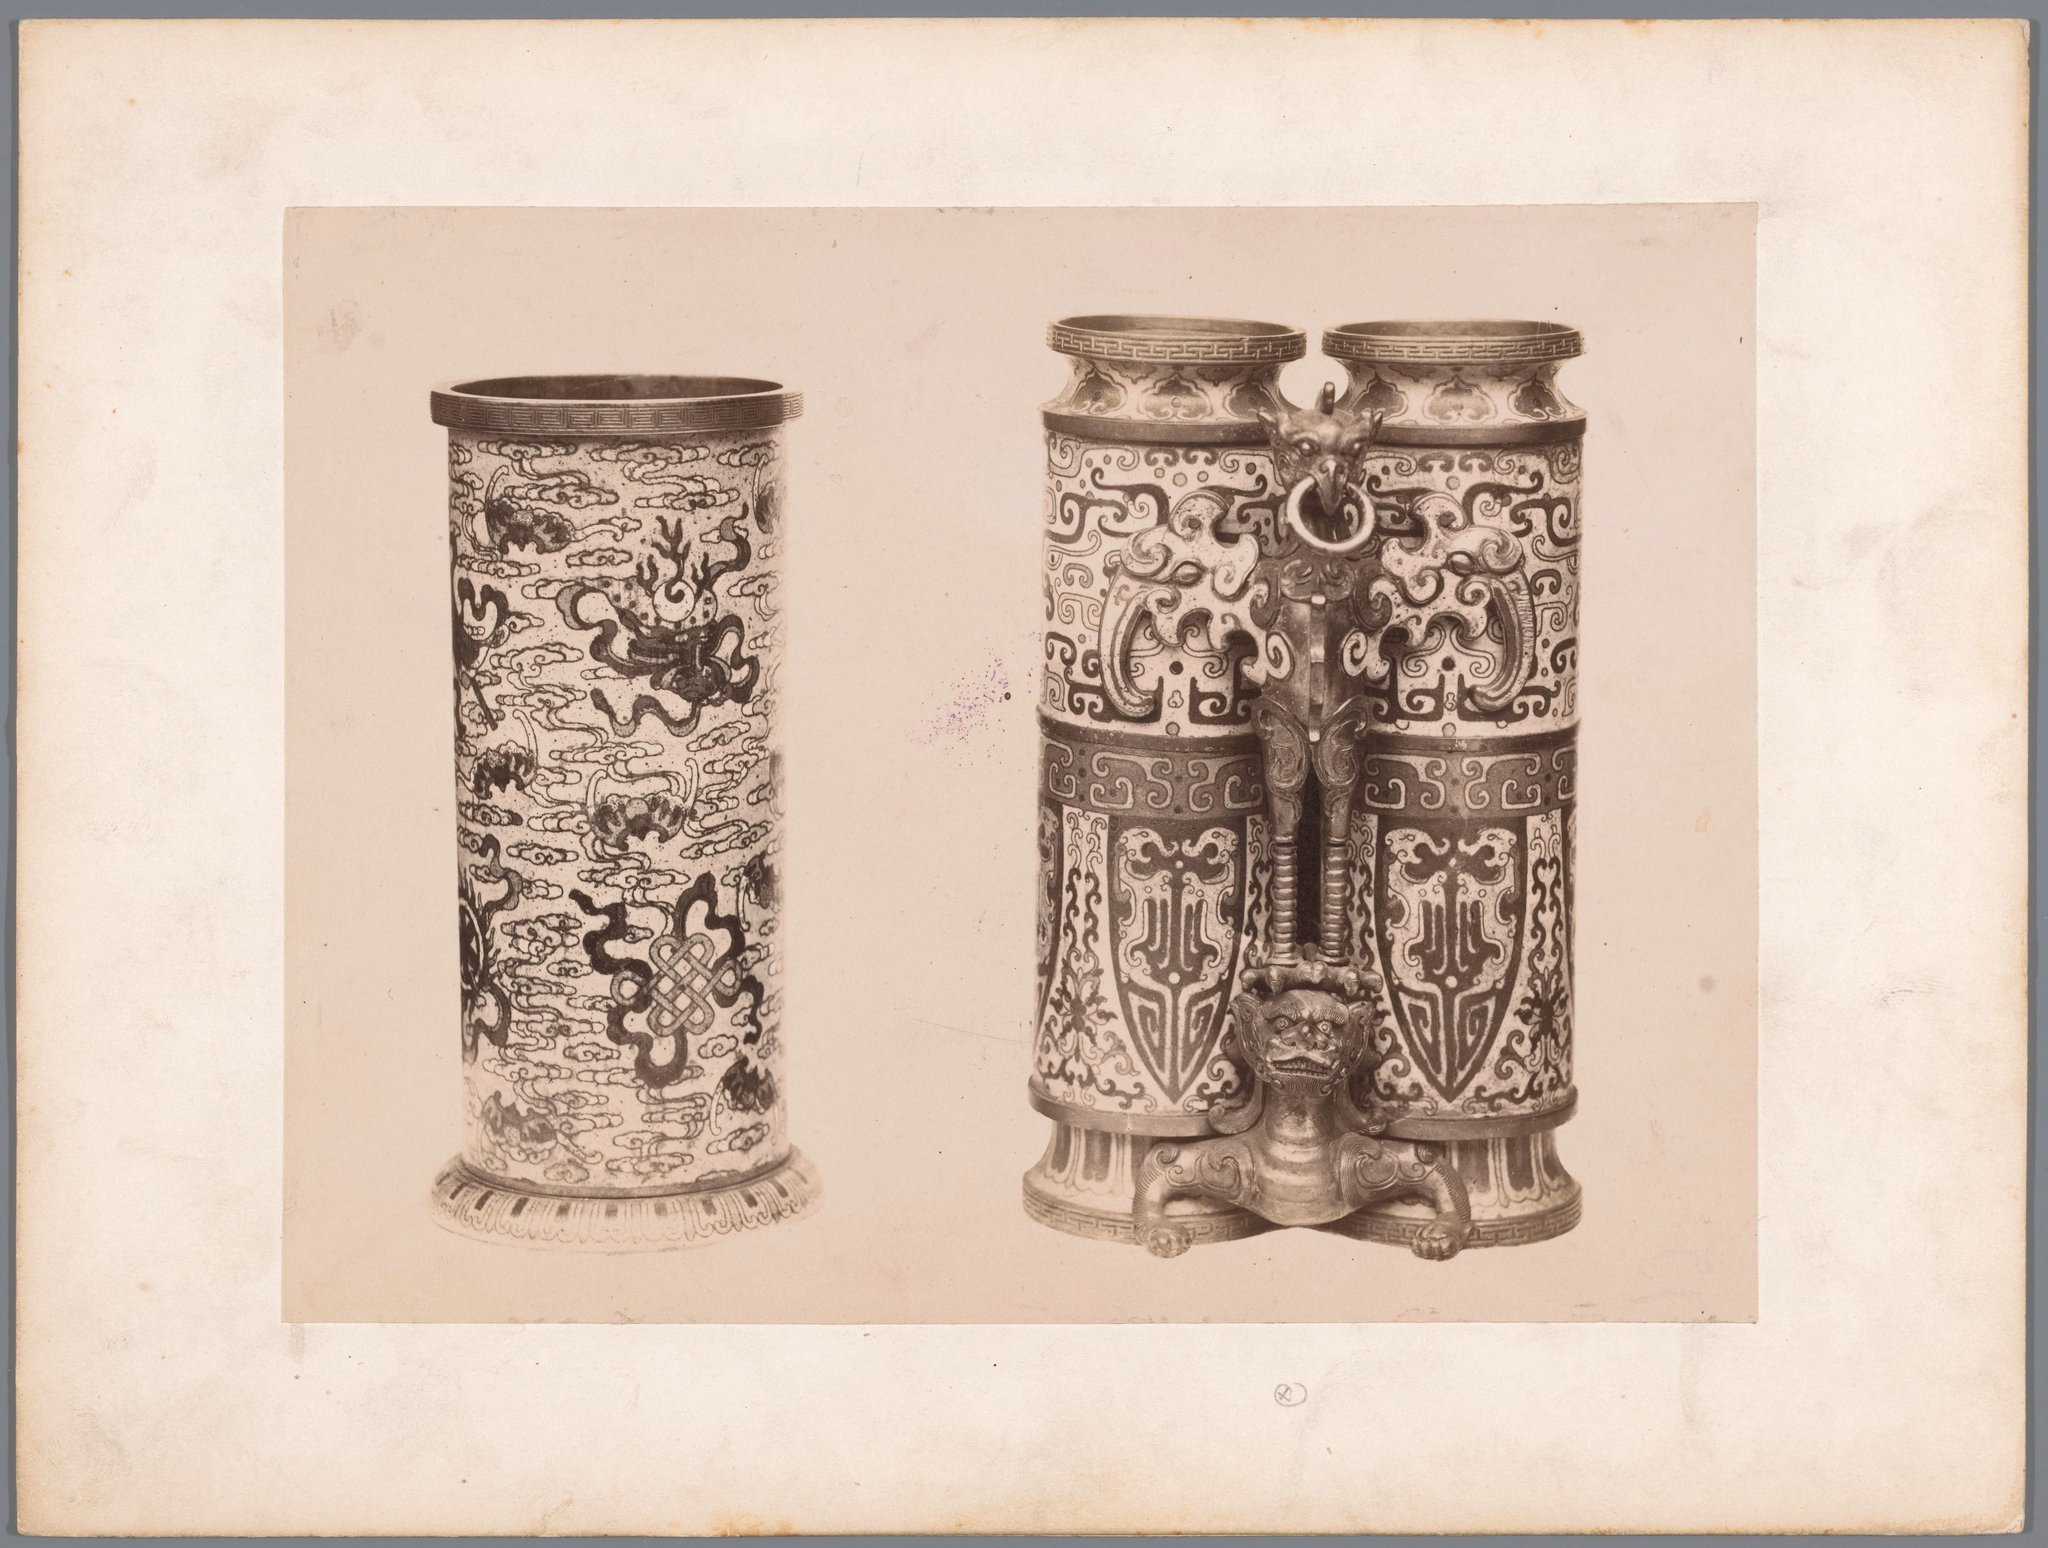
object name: photograph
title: Twee bekers gedecoreerd met Aziatische motieven met op de rechter beker een metalen ornament van een draak en vermoedelijk een feniks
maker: Anonymous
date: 1875-1900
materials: cardboard, photographic support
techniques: albumen print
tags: applied arts, arts and crafts; industrial design, dragon, container of ceramics: jar, jug, pot, vase, fabulous animals ~ birds: phoenix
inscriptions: collector's mark: Lugt 3937